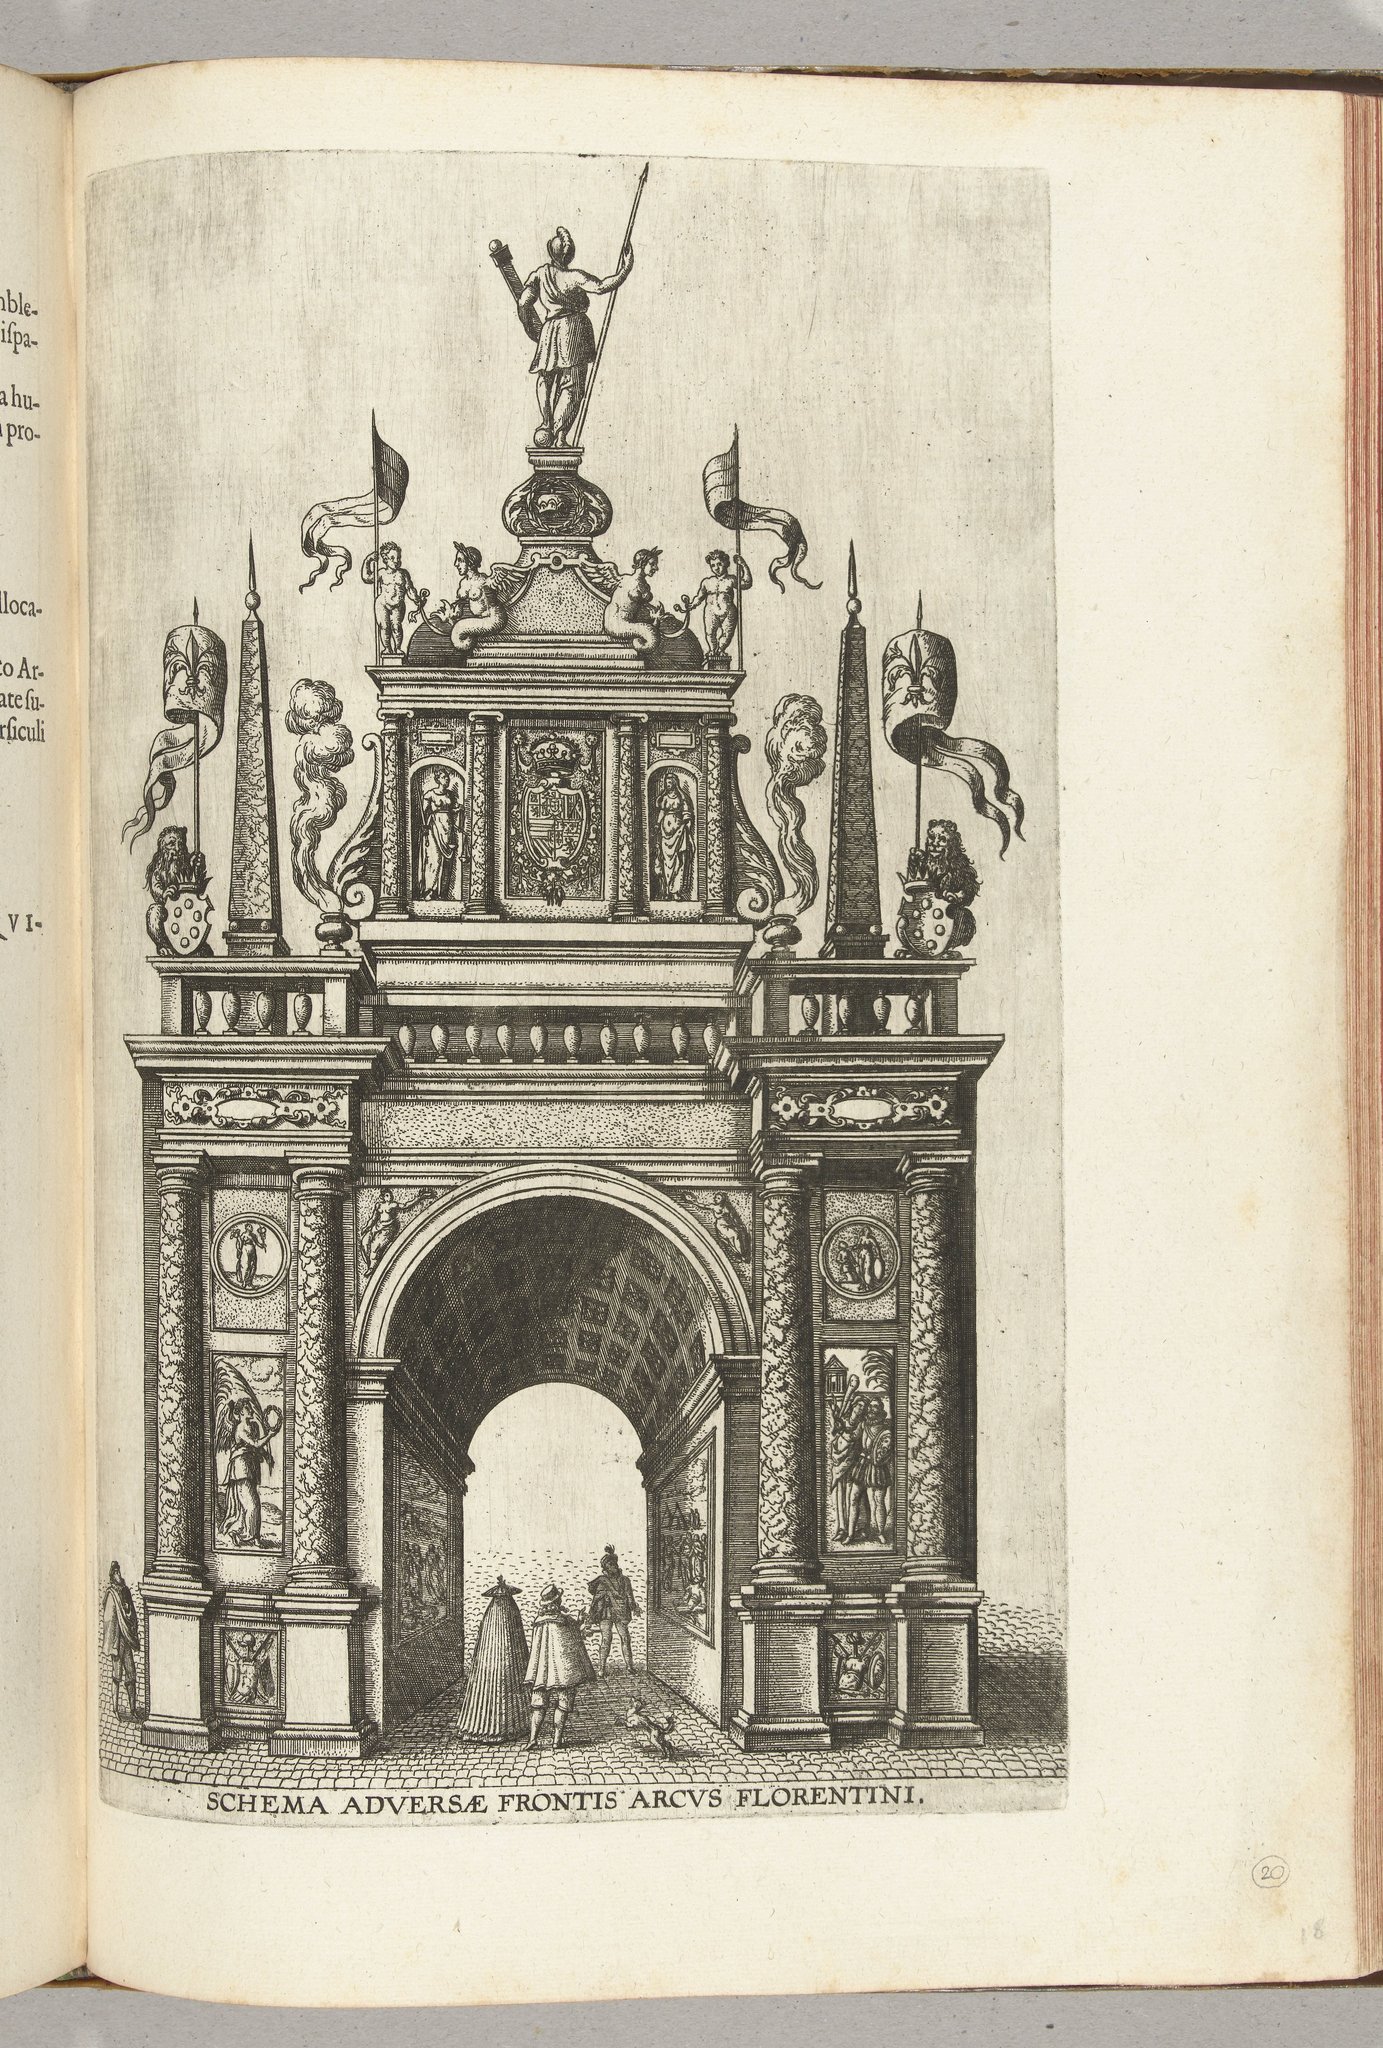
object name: print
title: Schema Adversae Frontis Arcus Florentini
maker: pieter van der borcht (i)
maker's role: print maker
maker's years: 1545-1608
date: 1594-1595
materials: paper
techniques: etching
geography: southern netherlands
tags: brussels, triumphal entry and public reception, pageant, 'entrée solennelle', 'joyeuse entrée', antwerp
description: Triomfboog van Florence (achterzijde), 1594. Opgericht in de Lange Nieuwstraat. Onderdeel van de beschrijving van de intocht van aartshertog Ernst te Antwerpen, 18 juli 1594, door Joannes Bochius, Descriptio publicae gratulationis, spectaculorum et ludorum, in adventu Sereniss. Principis Ernesti Archiducis Austriae, Ex Officina Plantiniana, Antwerpen 1595.